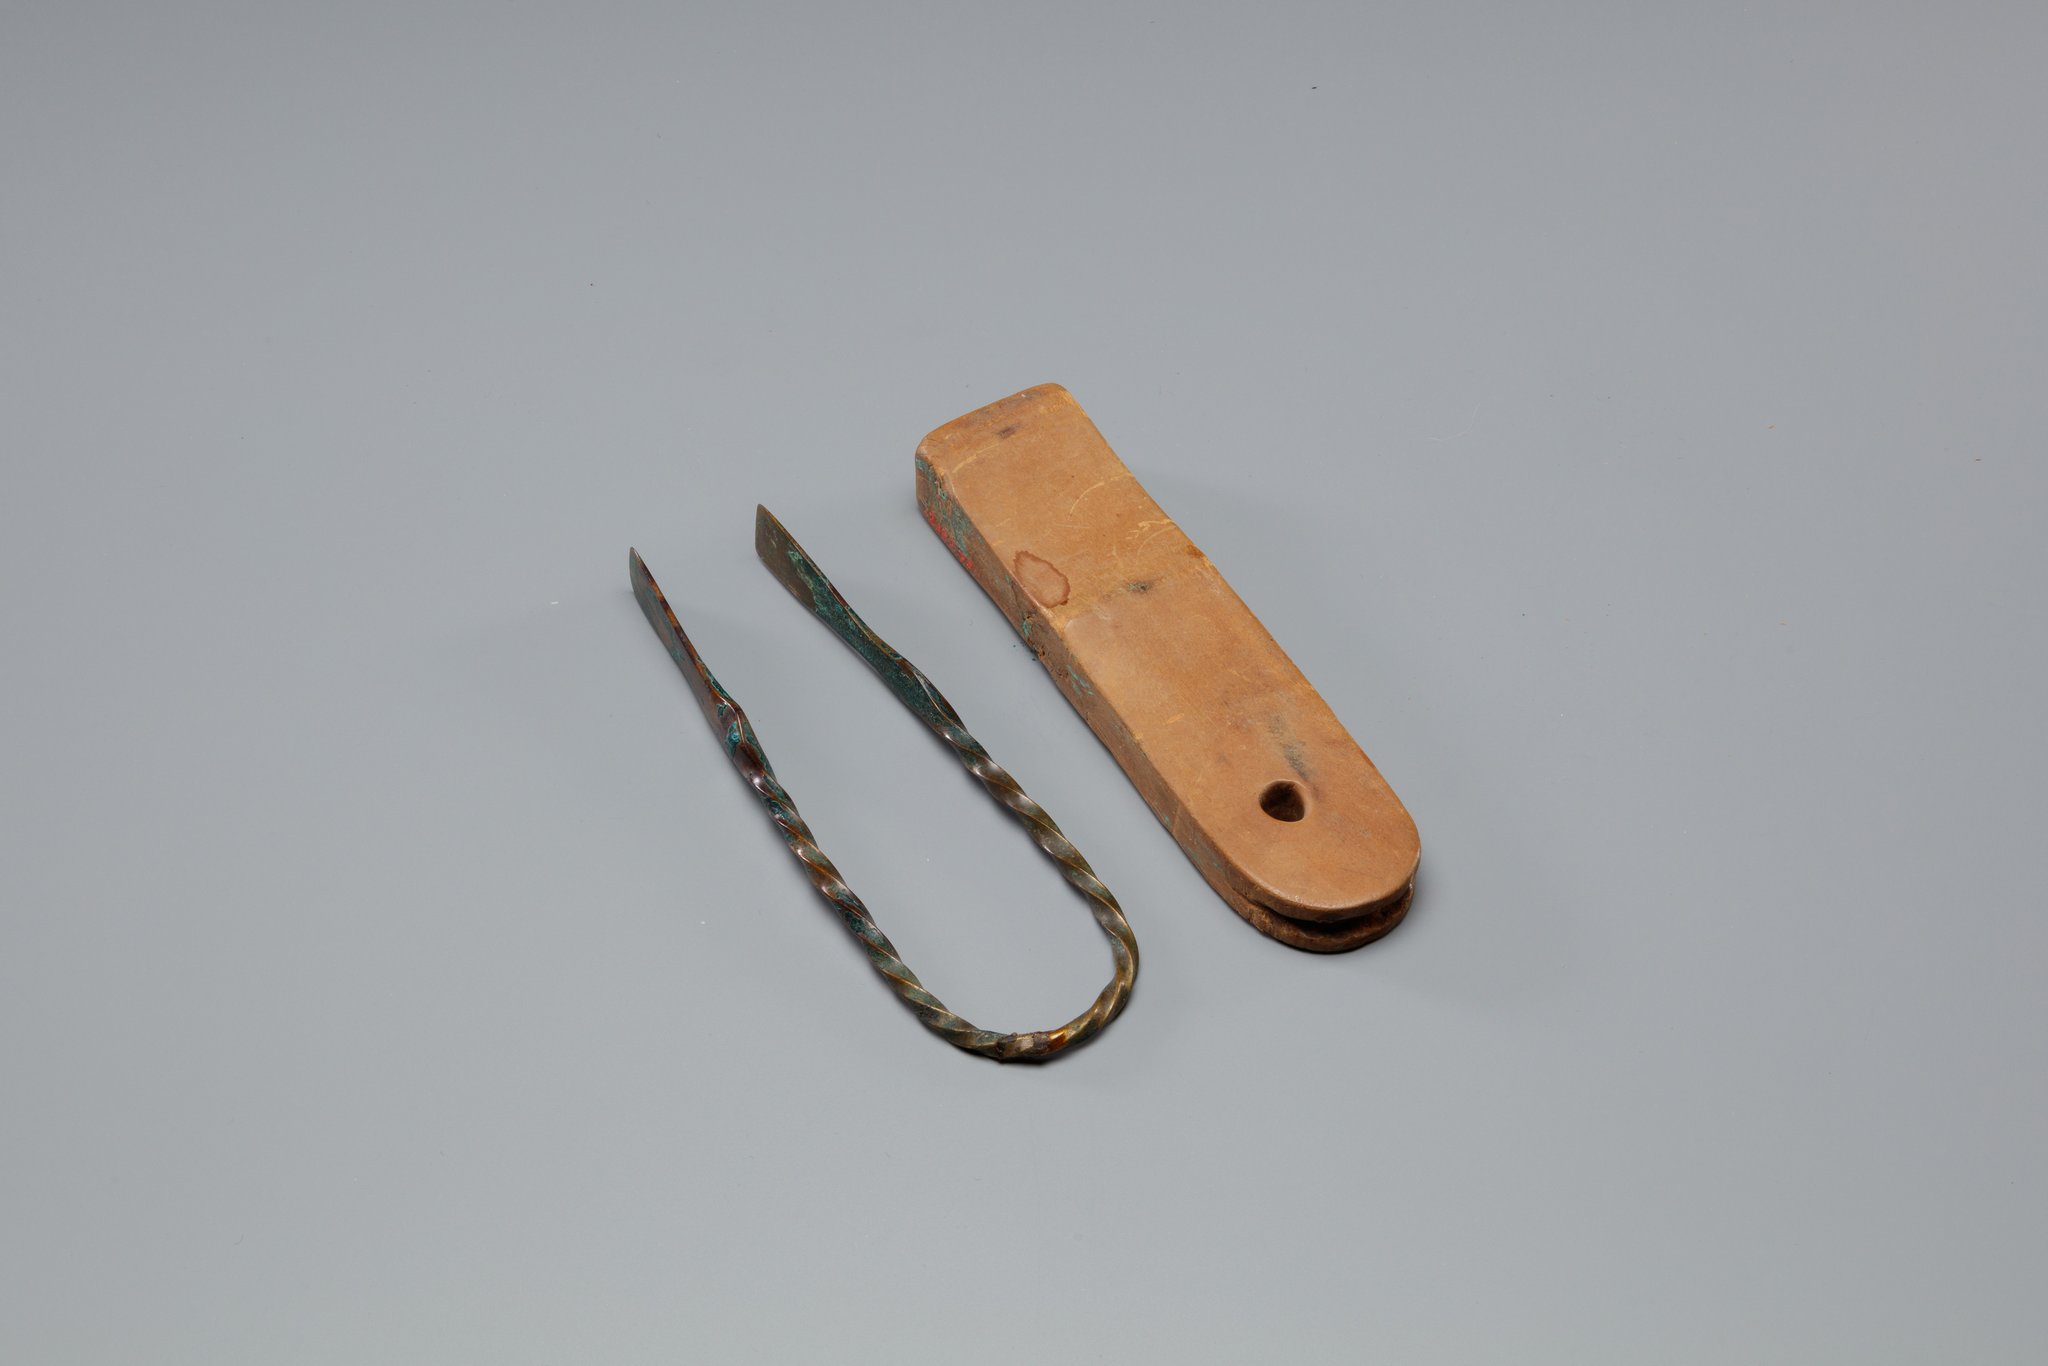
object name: tweezer, block, tweezer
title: Tweezers Mounted on a Wood Block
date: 1550-1295 BCE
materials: bronze, copper alloy, wood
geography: egypt